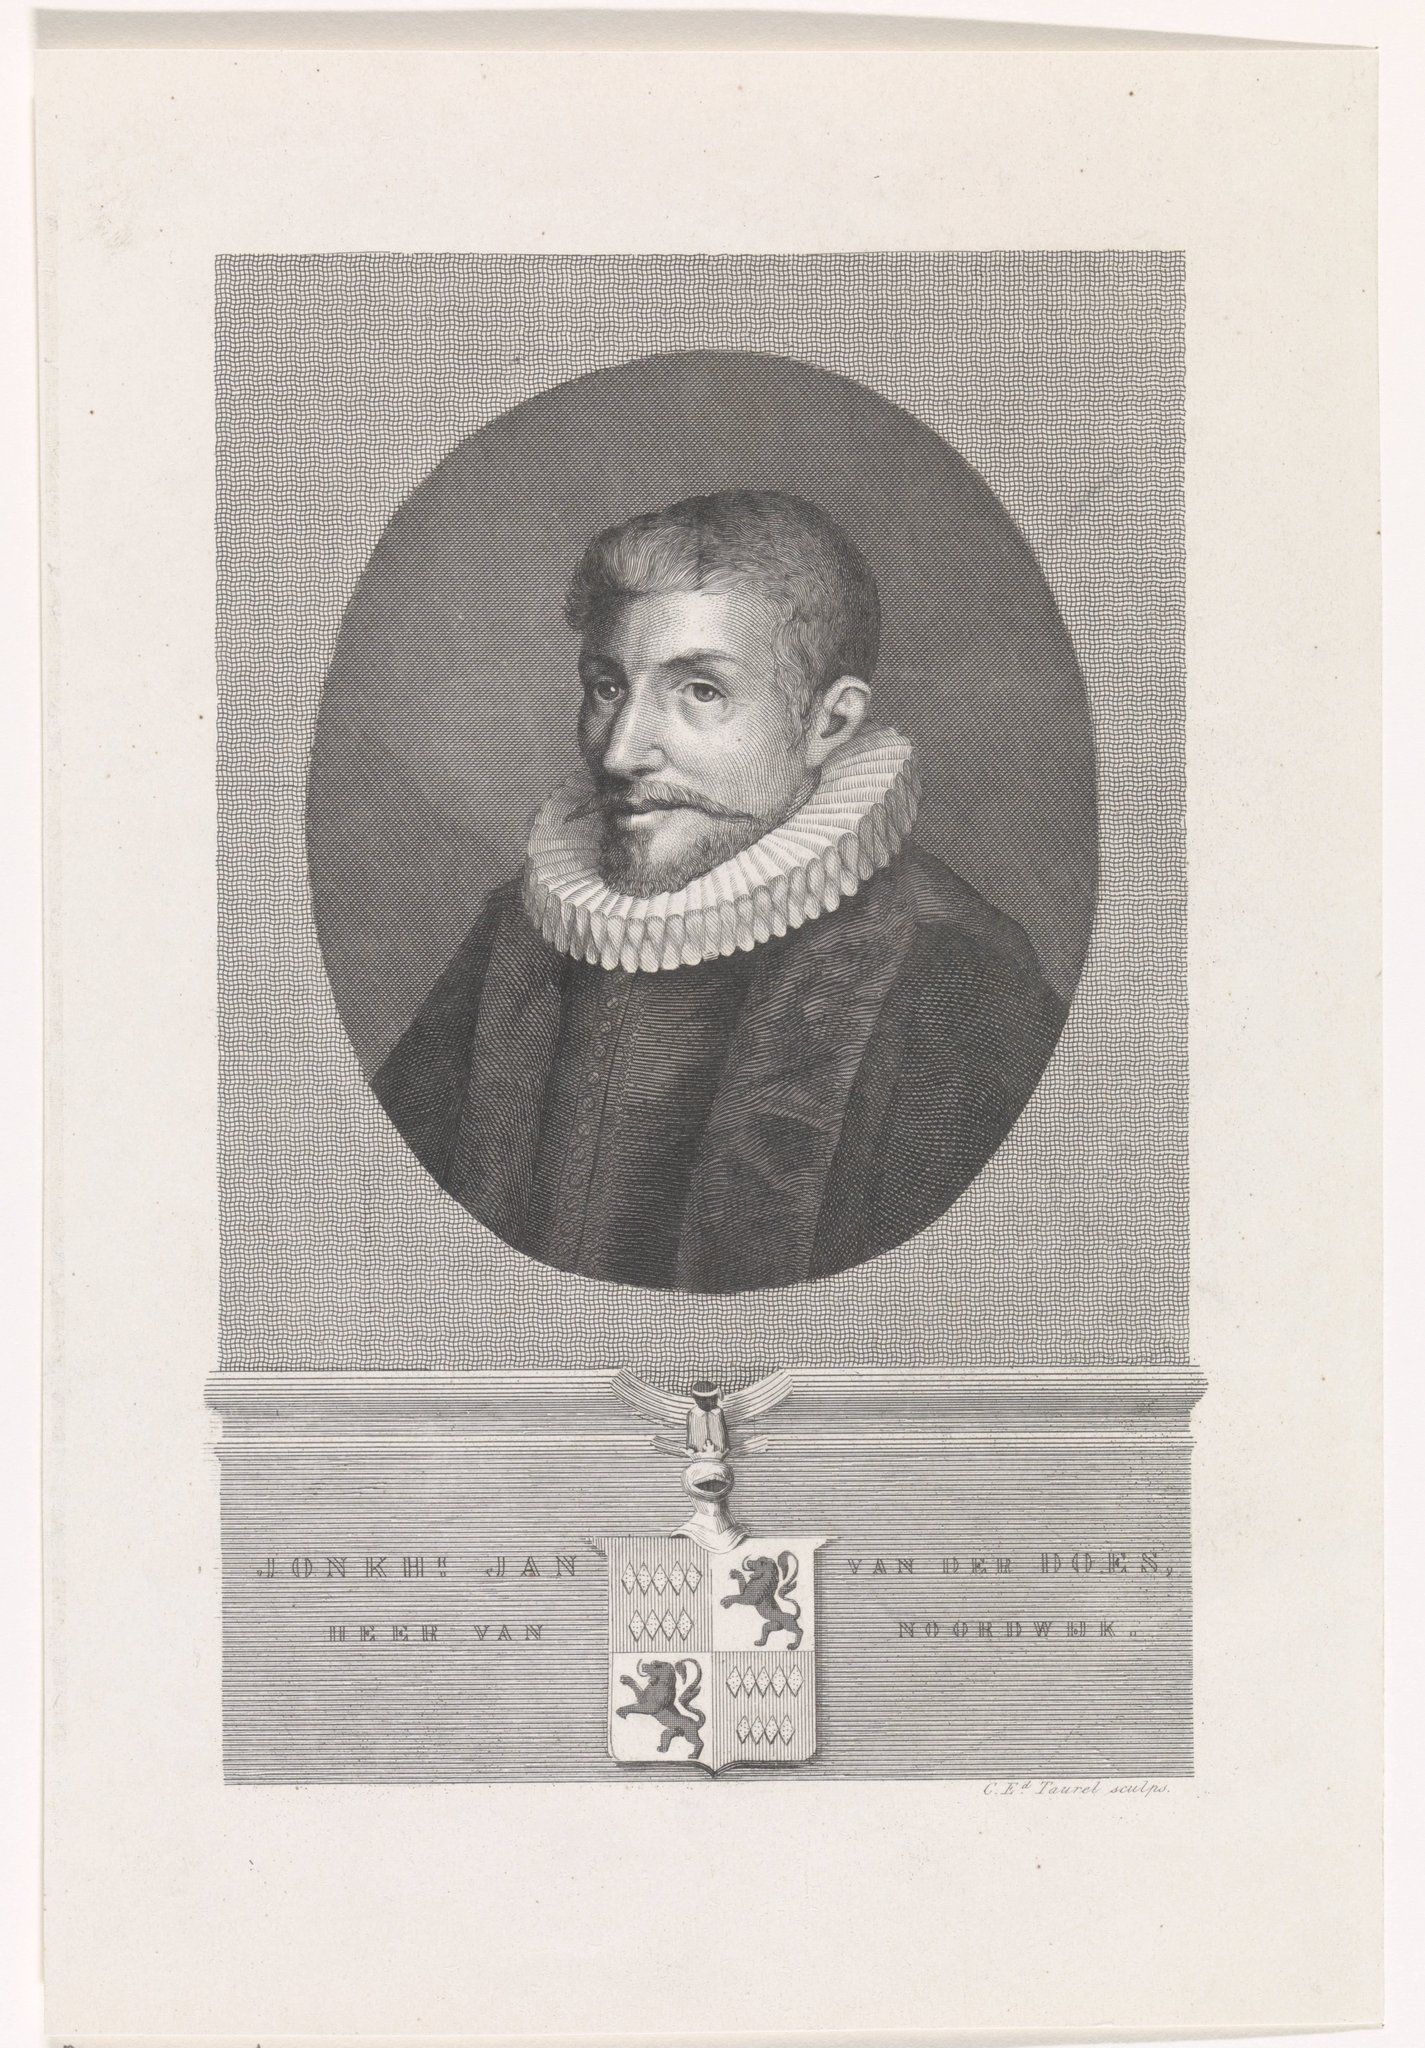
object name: print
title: Portret van Johan van der Does, heer van Noordwijk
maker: edouard taurel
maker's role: draughtsman, print maker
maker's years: 1824-1892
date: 1841-1879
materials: paper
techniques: letterpress printing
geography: amsterdam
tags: bevelhebber, bibliothecaris, bestuurder, jan van der does (heer van noordwijk en kattendijke)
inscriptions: collector's mark: Lugt 2228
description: Prent ook gebruikt als illustratie voor: Arend, Johannes Pieter. Algemeene geschiedenis des vaderlands van de vroegste tijden tot op heden. 5 delen. Amsterdam: J.F. Schleijer, 1841-1884. dl. II.5, p. 386.